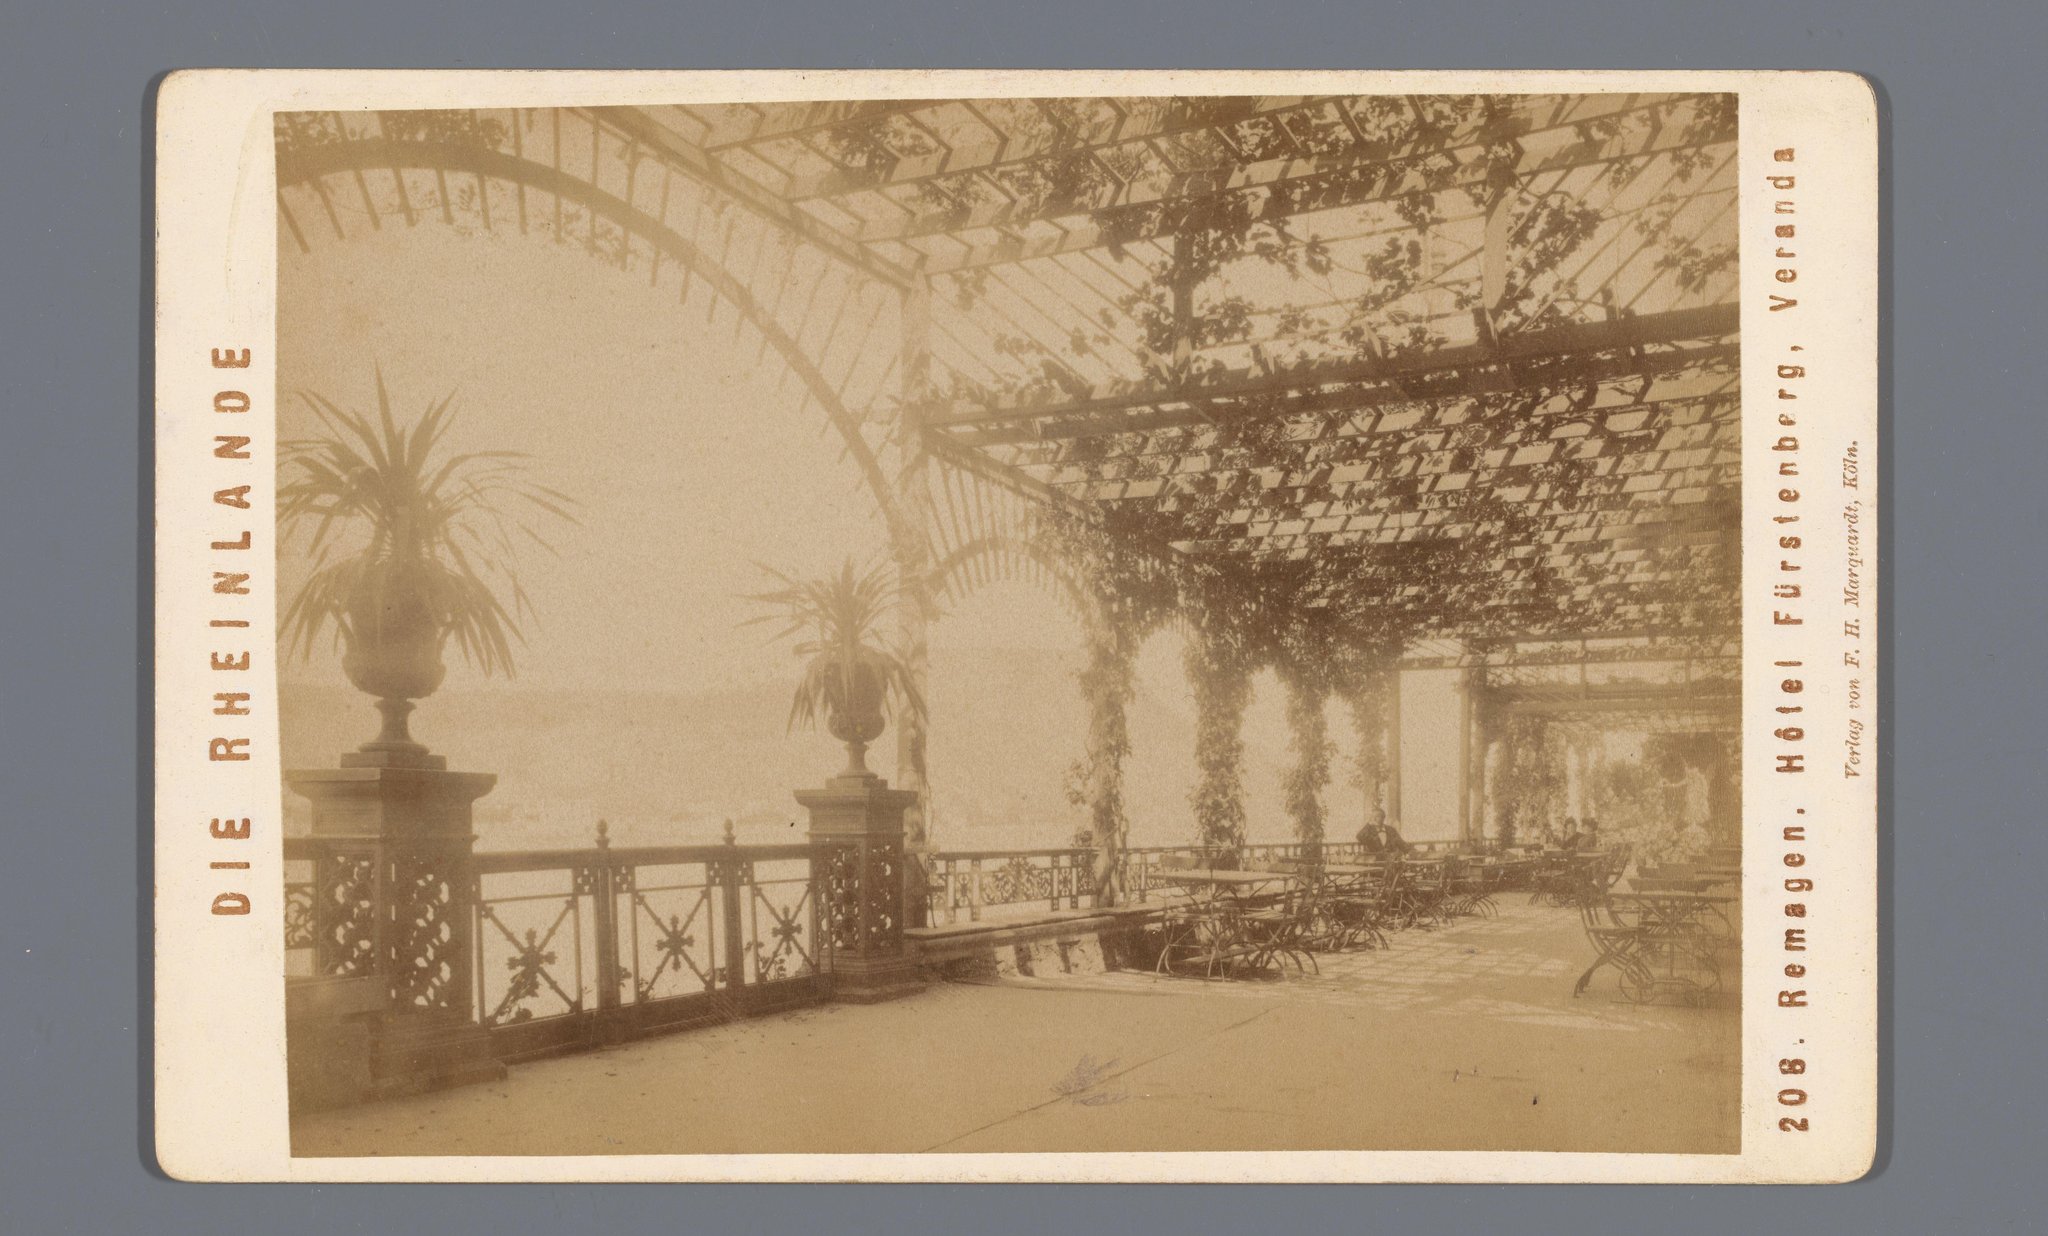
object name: cabinet photograph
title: Veranda van het Hotel Fürstenberg te Remagen, Duitsland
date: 1889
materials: cardboard, paper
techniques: albumen print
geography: cologne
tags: loggia, verandah, porch, hotel, hostelry, inn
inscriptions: number: ‘208.’, inscription: ‘Anselm Schmidtz/ Königl. Hof-Photograph/ COELN A/RH./ 1889/ HAAKE & ALBERS, FRANKFURT A/M.’